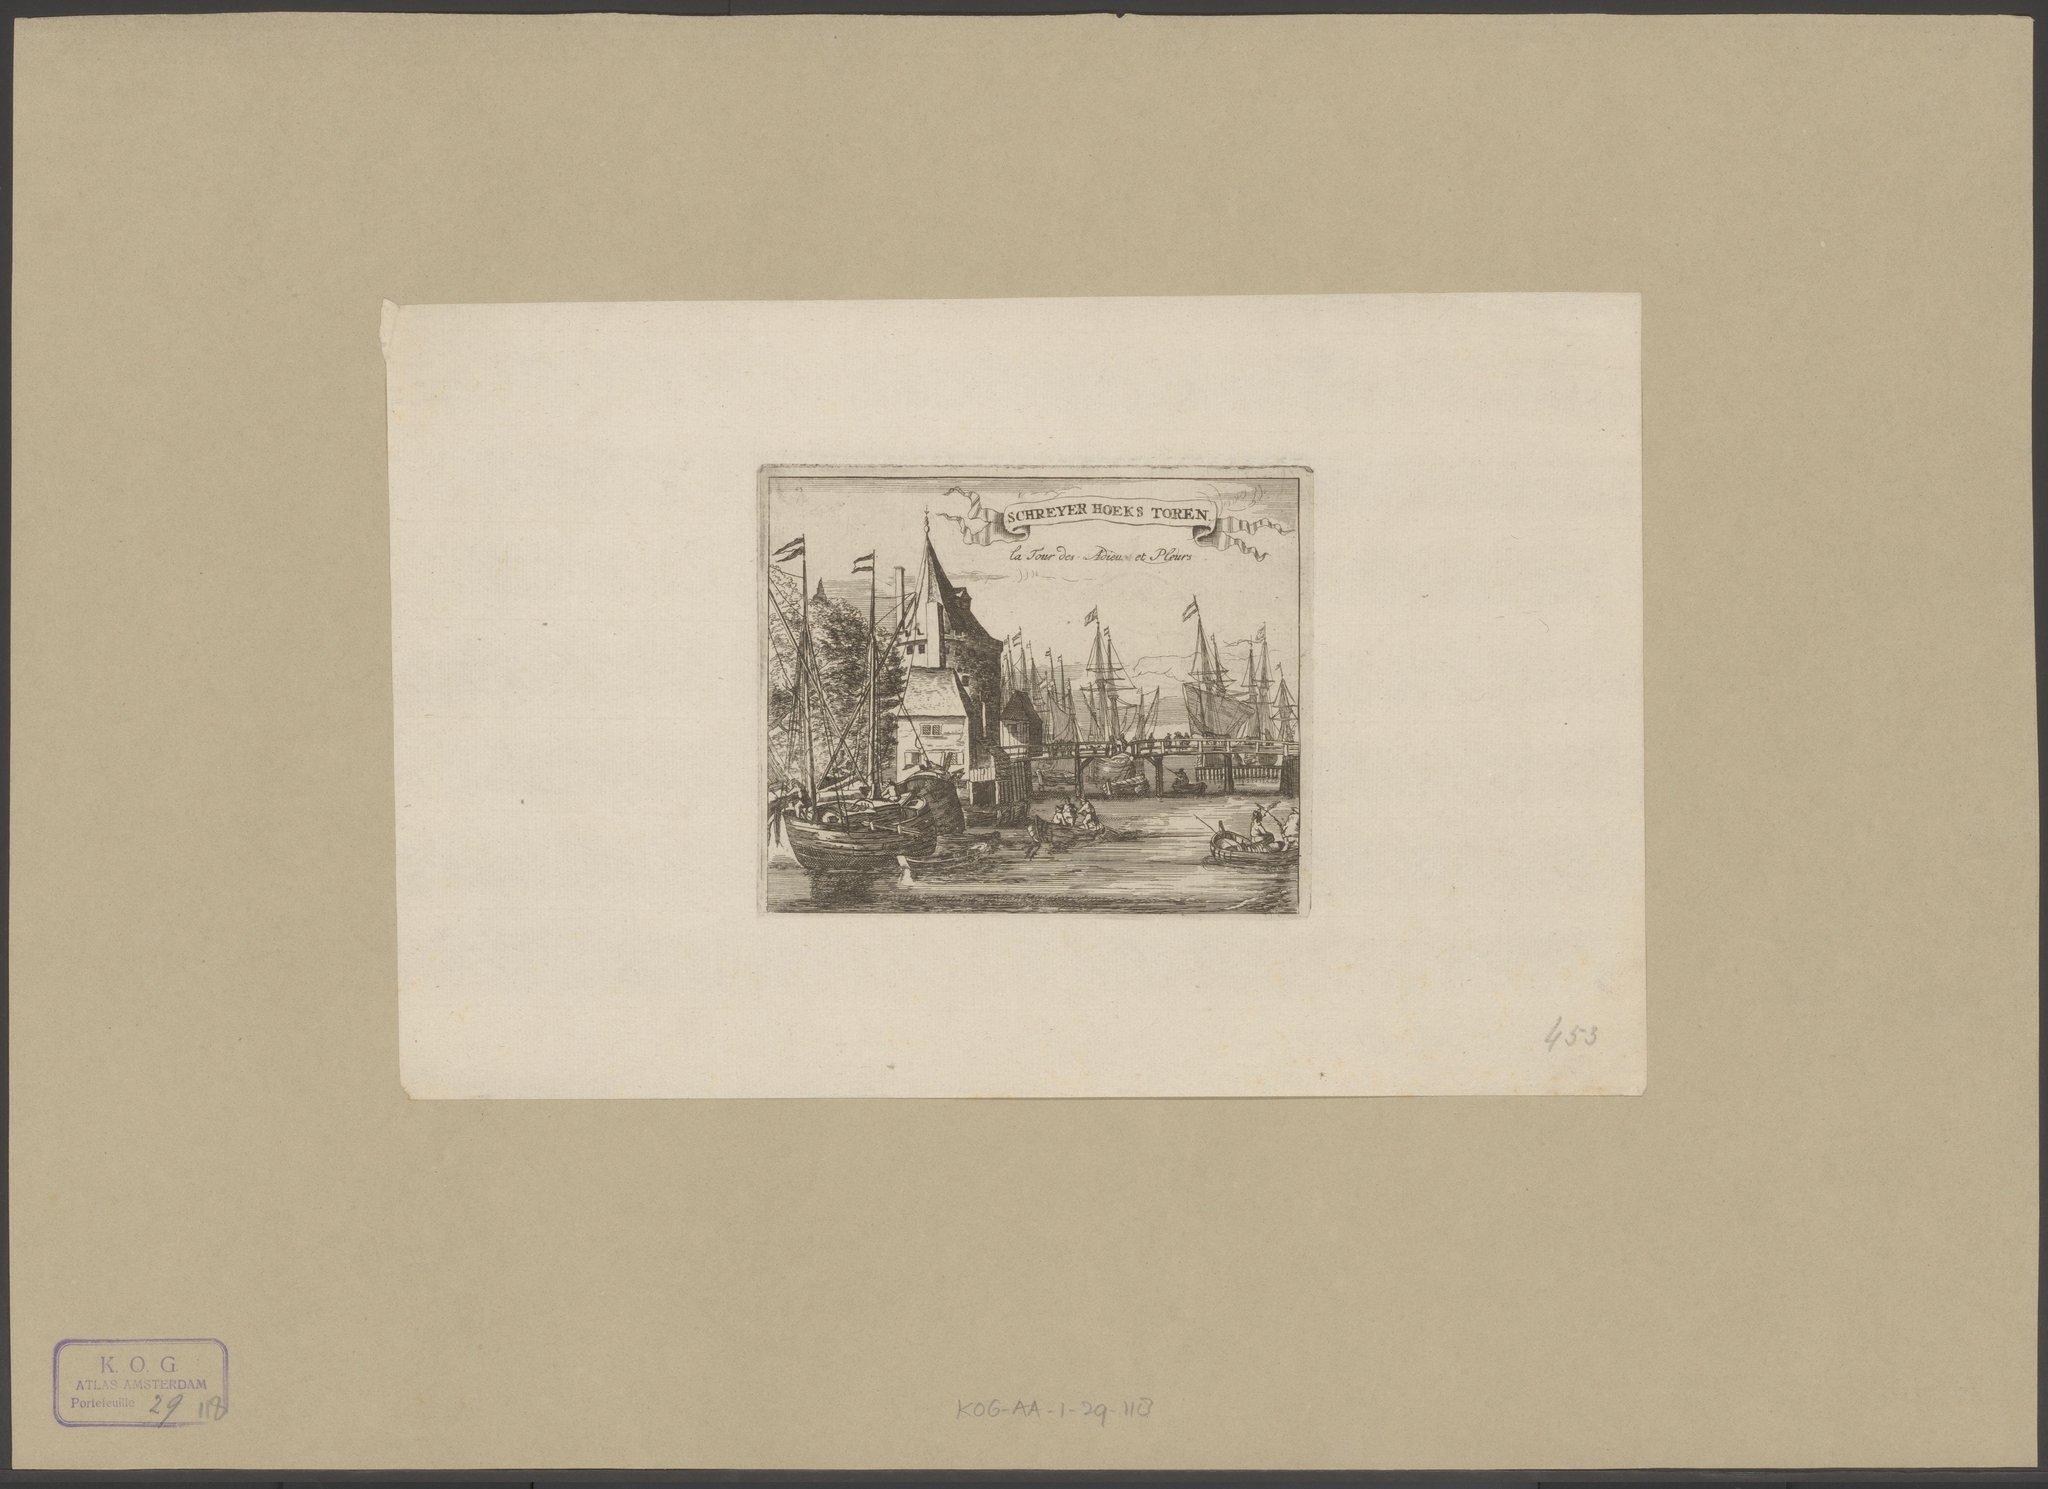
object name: print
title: Gezicht op de Schreierstoren te Amsterdam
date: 1663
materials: paper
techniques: engraving, etching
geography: northern netherlands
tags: sailing-ship, sailing-boat, towers ~ fortified city, rowing-boat, canoe, etc., canals, waters (in city) (+ city(-scape) with figures, staffage)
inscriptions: collector's mark: Lugt 1641b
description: Onderwerpsrubriek binnen de Atlas Amsterdam: Schreierstoren.